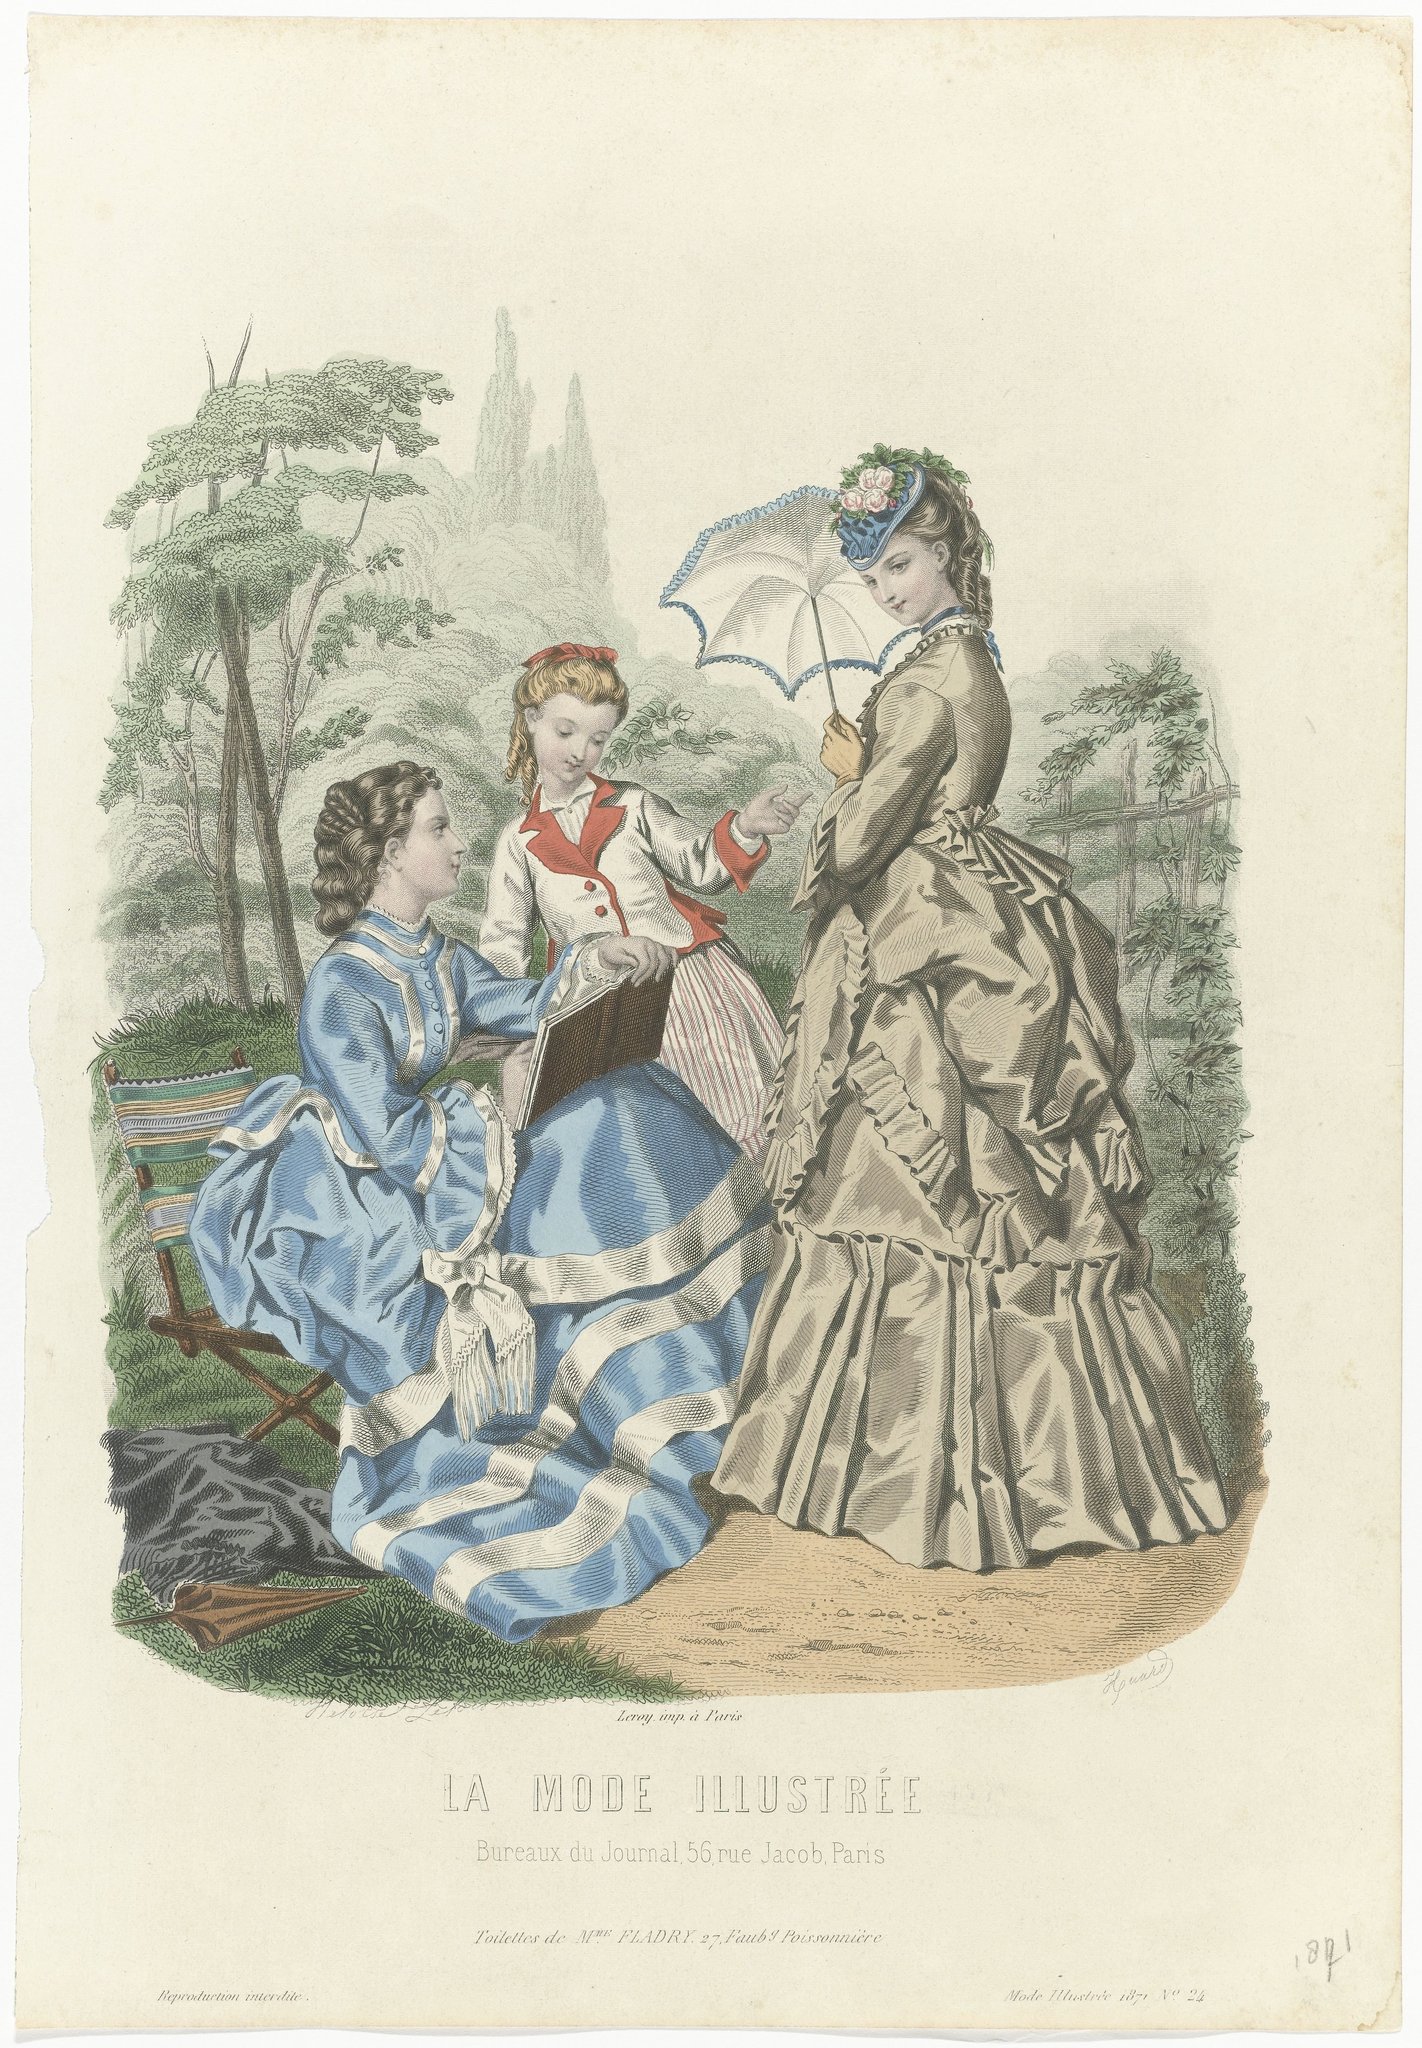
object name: fashion print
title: La Mode Illustrée, 1871, No. 24: Toilettes de Mme Fladry (...)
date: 1871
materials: paper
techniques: engraving, hand coloring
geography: paris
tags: bow (ornamental part of clothing) (+ women's clothes), skirt (+ girls' clothes), neck-gear ~ clothing (+ girls' clothes), coat (+ girls' clothes), head-gear (+ women's clothes), fashion plates, gloves, mittens, etc. (+ women's clothes), dress, gown (+ women's clothes), draughtsman at work - cc - out of doors, necklace (+ women's clothes), parasol, sunshade (+ women's clothes)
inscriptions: title: ‘La Mode Illustrée’, caption: ‘Toilettes de Mme Fladry, 27, Faubg Poissonniére’, address: ‘Bureaux du Journal, 56, Rue Jacob. Paris’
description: Twee vrouwen en een meisje in 'toilettes' van Fladry. Prent uit het modetijdschrift La Mode Illustrée (1860-1937).